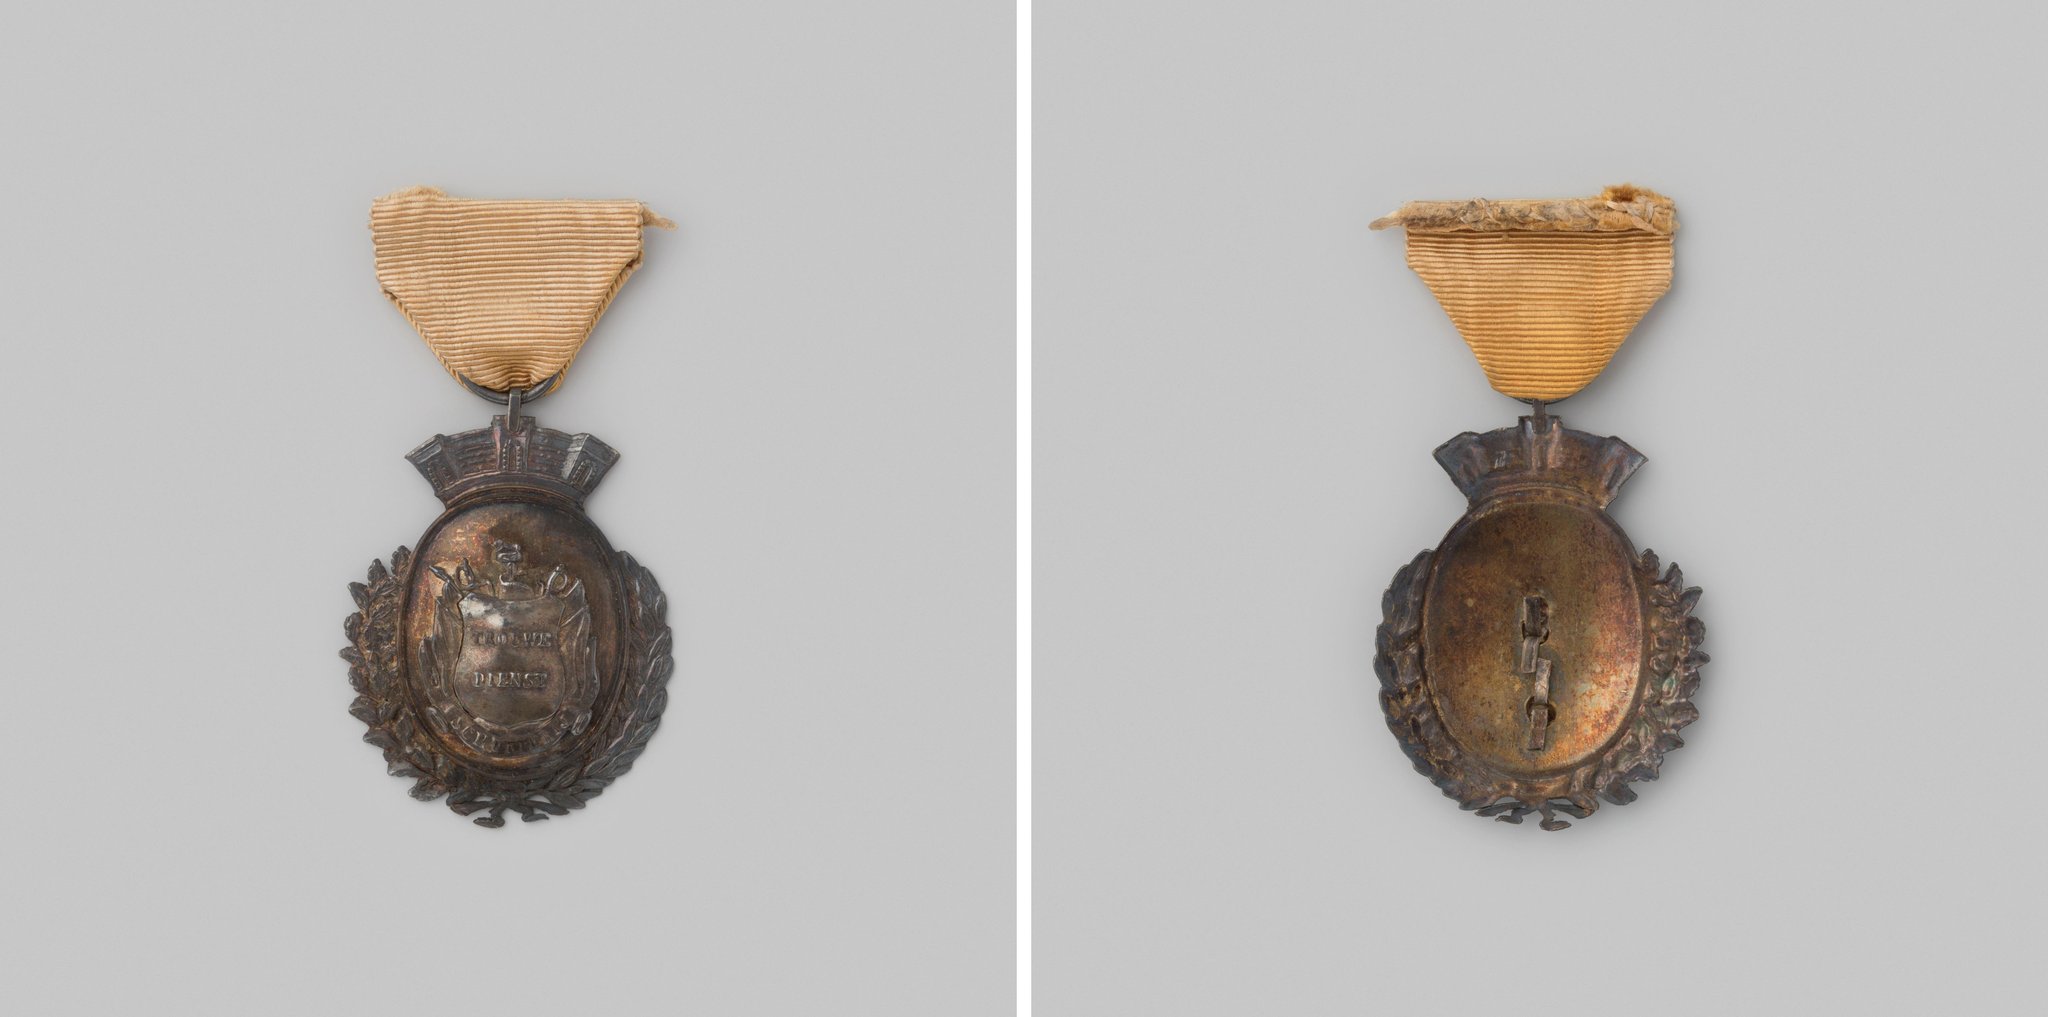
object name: honorary medal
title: Ereteken voor eervolle, langdurige en werkelijke dienst bij de schutterij voor onderofficieren en minderen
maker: Anonymous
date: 1851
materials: silver, textile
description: Zilveren draagpenning met oog, ring en lint.